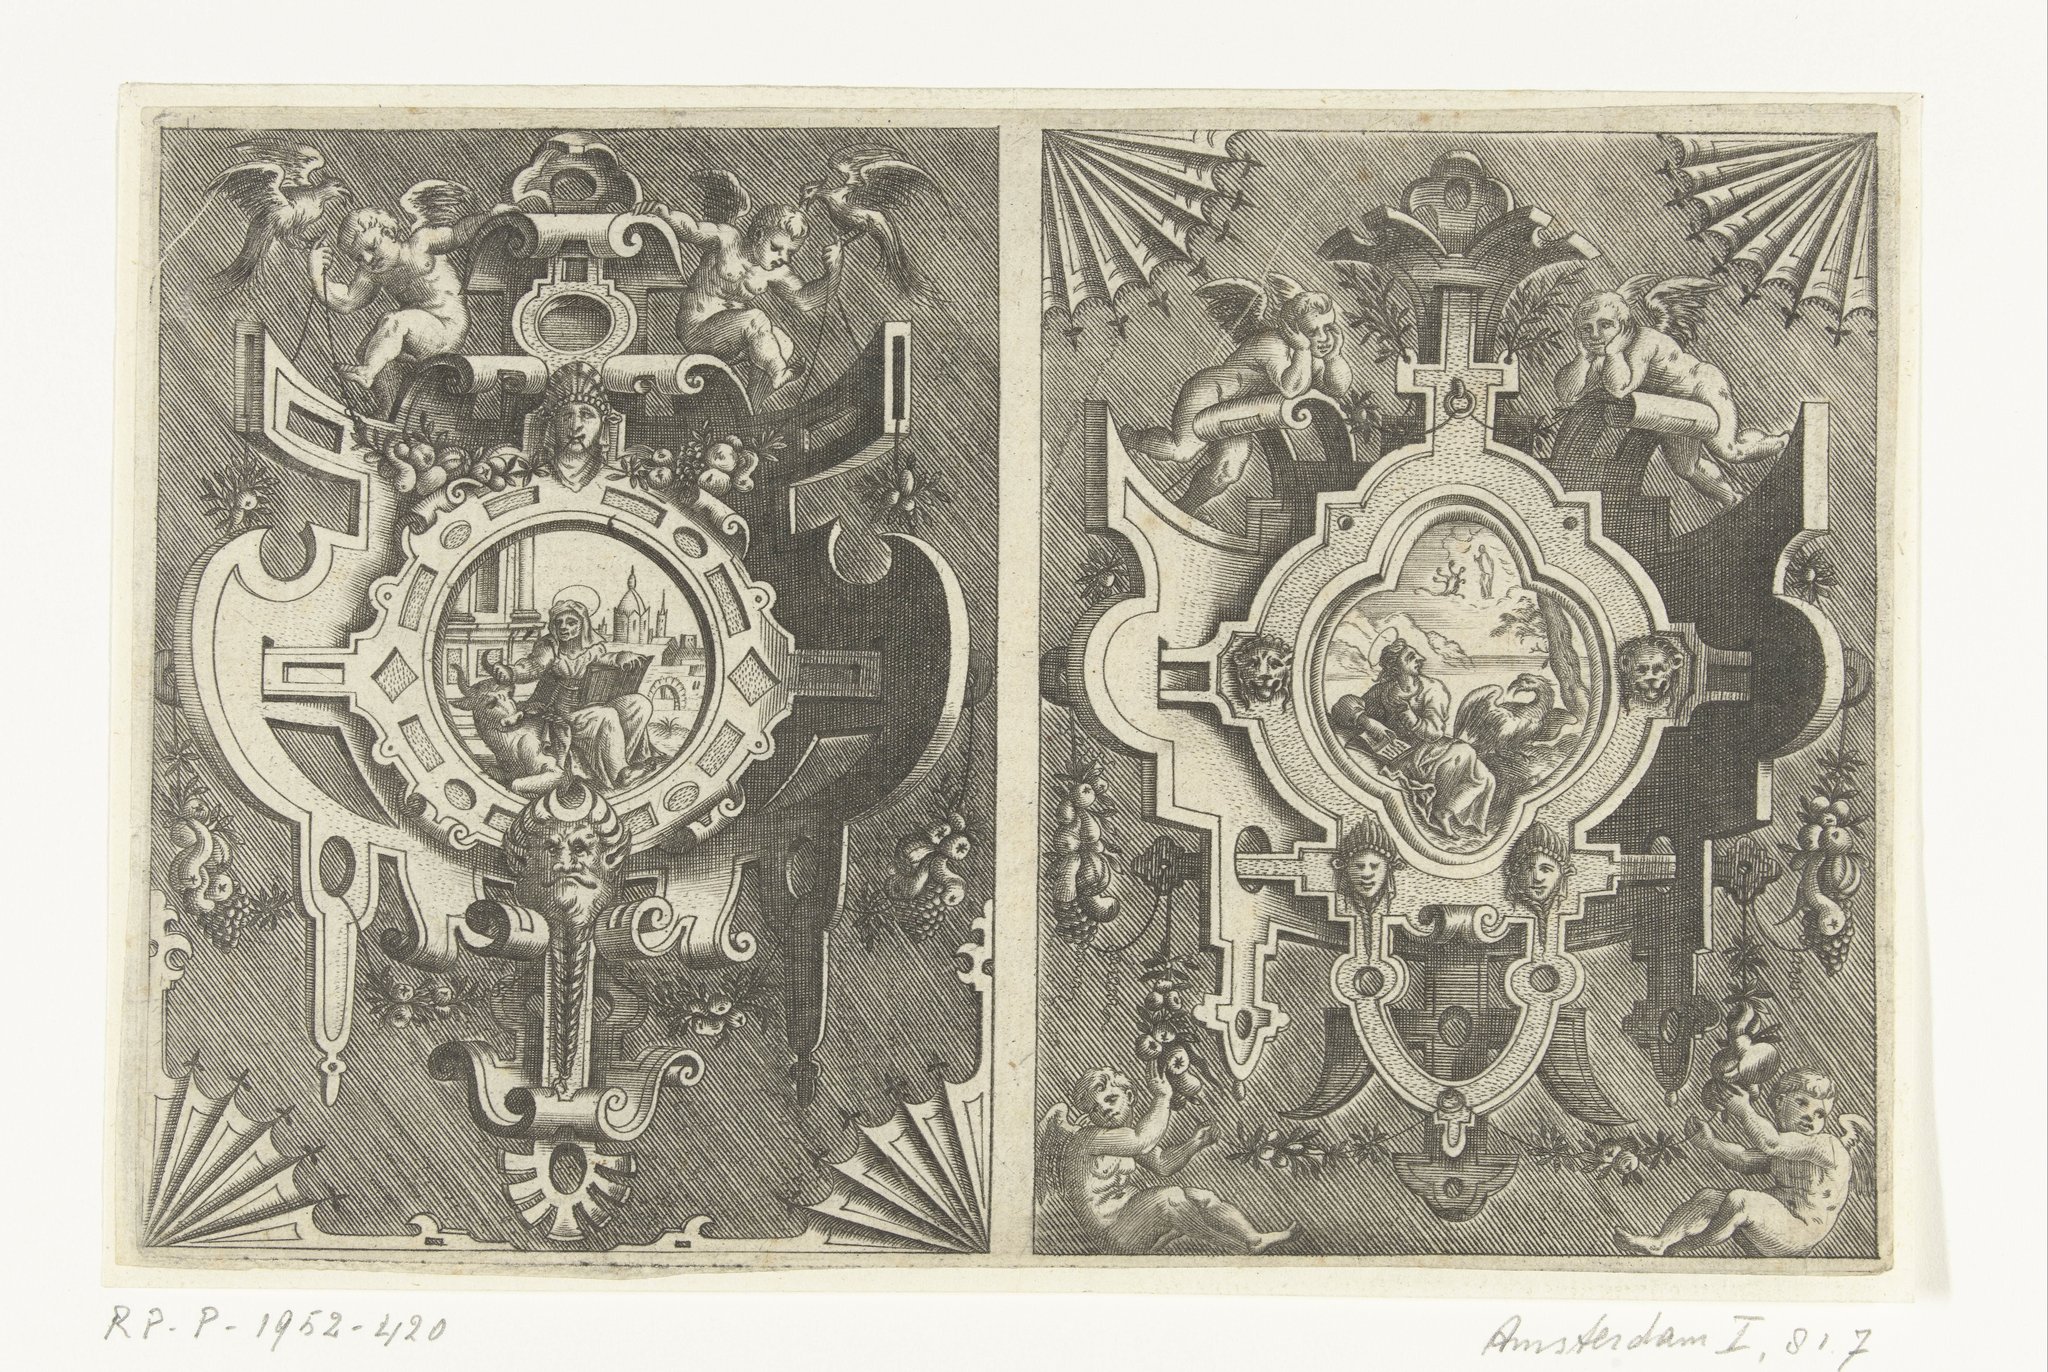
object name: print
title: Twee evangelisten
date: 1566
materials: paper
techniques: engraving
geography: netherlands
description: Twee cartouches op één blad, elk met de voorstelling van een evangelist: links Lucas en rechts Johannes. Blad uit serie bestaande uit een titelblad en 15 van de 16 bladen met cartouches met bijbelse en mythologische voorstellingen in een omlijsting van rolwerk en grotesken.